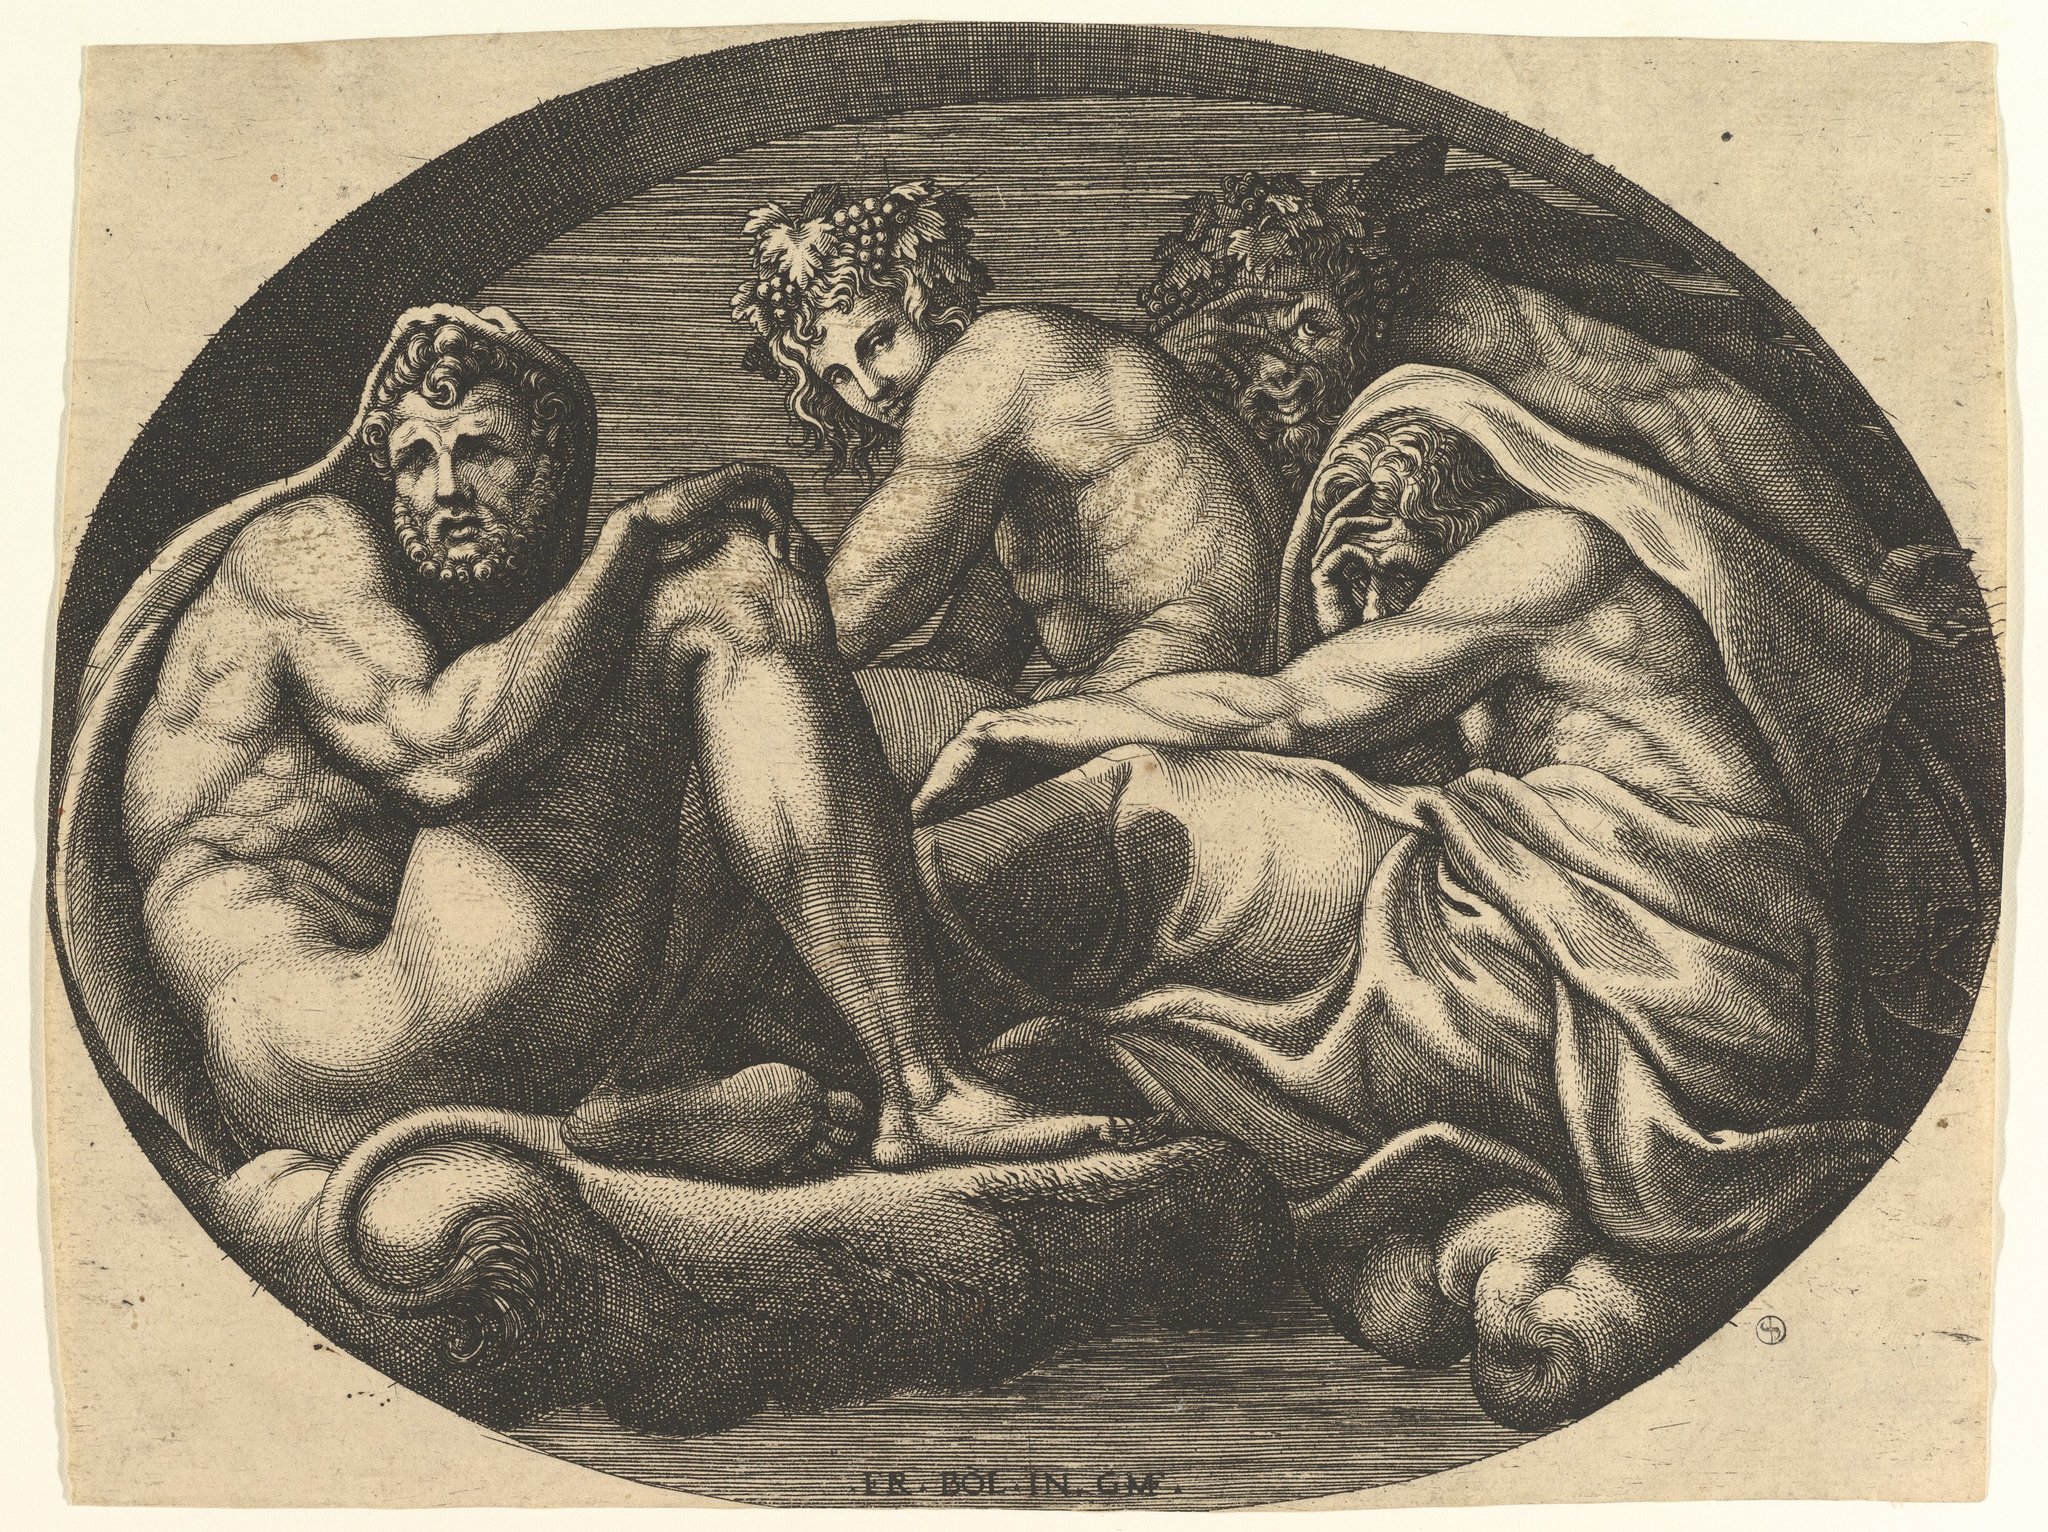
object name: print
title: Hercules, Bacchus, Pan, and Saturn(?), from a series of eight compositions after Francesco Primaticcio's designs for the ceiling of the Ulysses Gallery (destroyed 1738–39) at Fontainebleau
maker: giorgio ghisi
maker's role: artist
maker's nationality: italian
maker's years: 1515-1582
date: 1560-1569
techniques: engraving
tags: hercules,bacchus,saturn